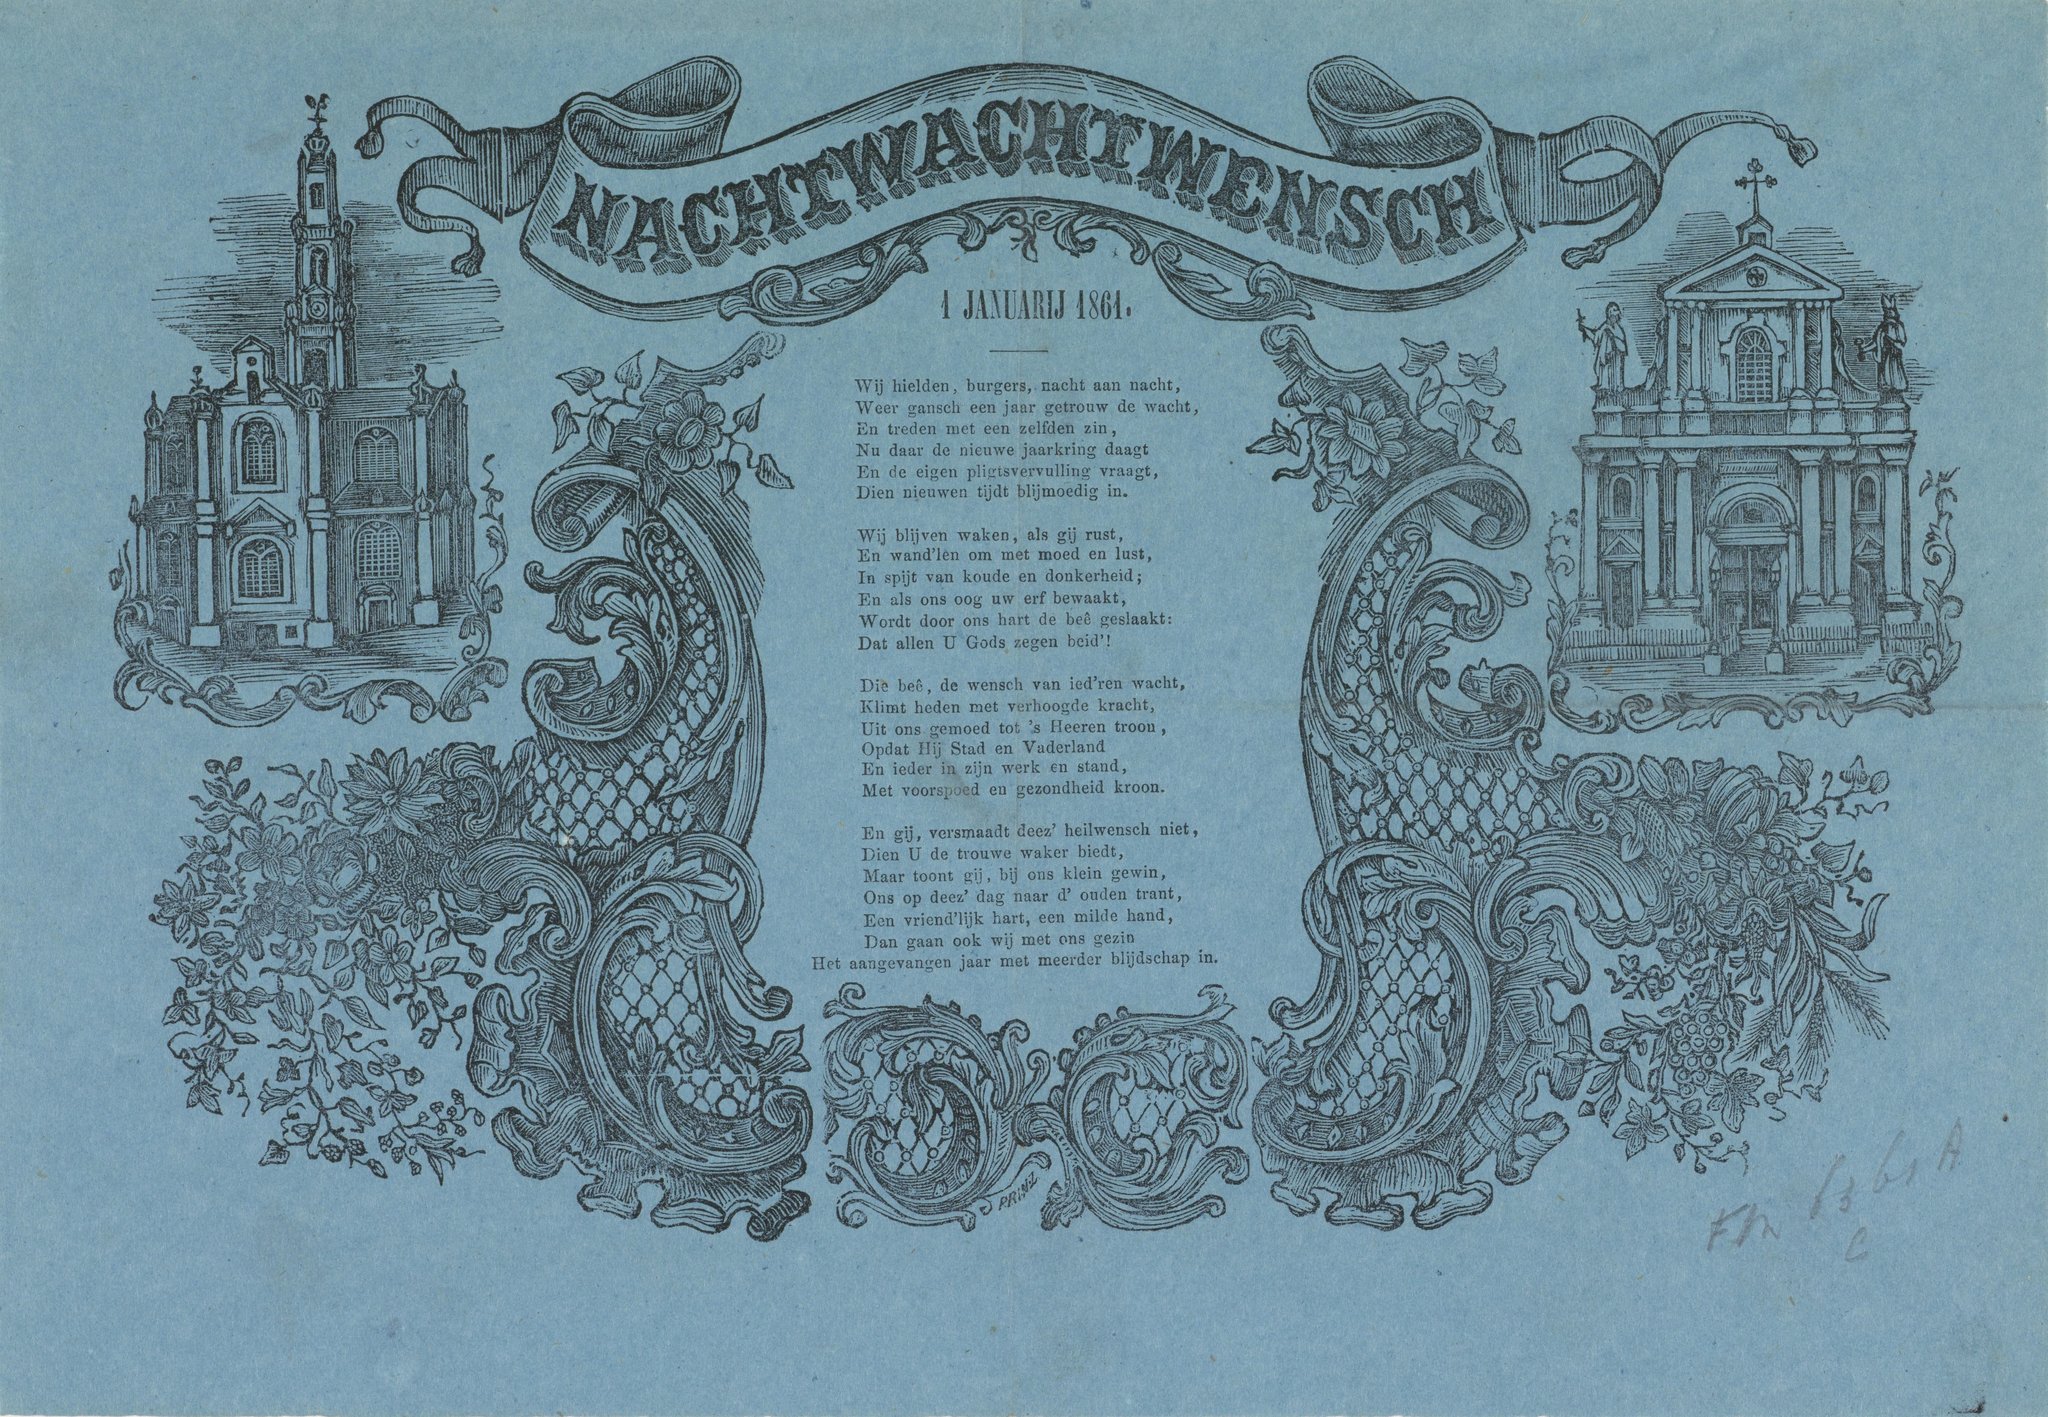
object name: print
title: Nachtwachtwensch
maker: friedrich robert prinz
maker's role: print maker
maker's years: 1820-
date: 1860-1861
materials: paper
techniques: letterpress printing, engraving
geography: amsterdam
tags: night patrol, church (exterior), amsterdam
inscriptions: collector's mark: Lugt 2228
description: Nieuwjaarswens van de Amsterdamse nachtwacht (ratelwacht) voor het jaar 1861. Centraal een gedicht in vier verzen, hieromheen randwerk en gezichten op de Westerkerk en de kerk De Duif op de Prinsengracht.